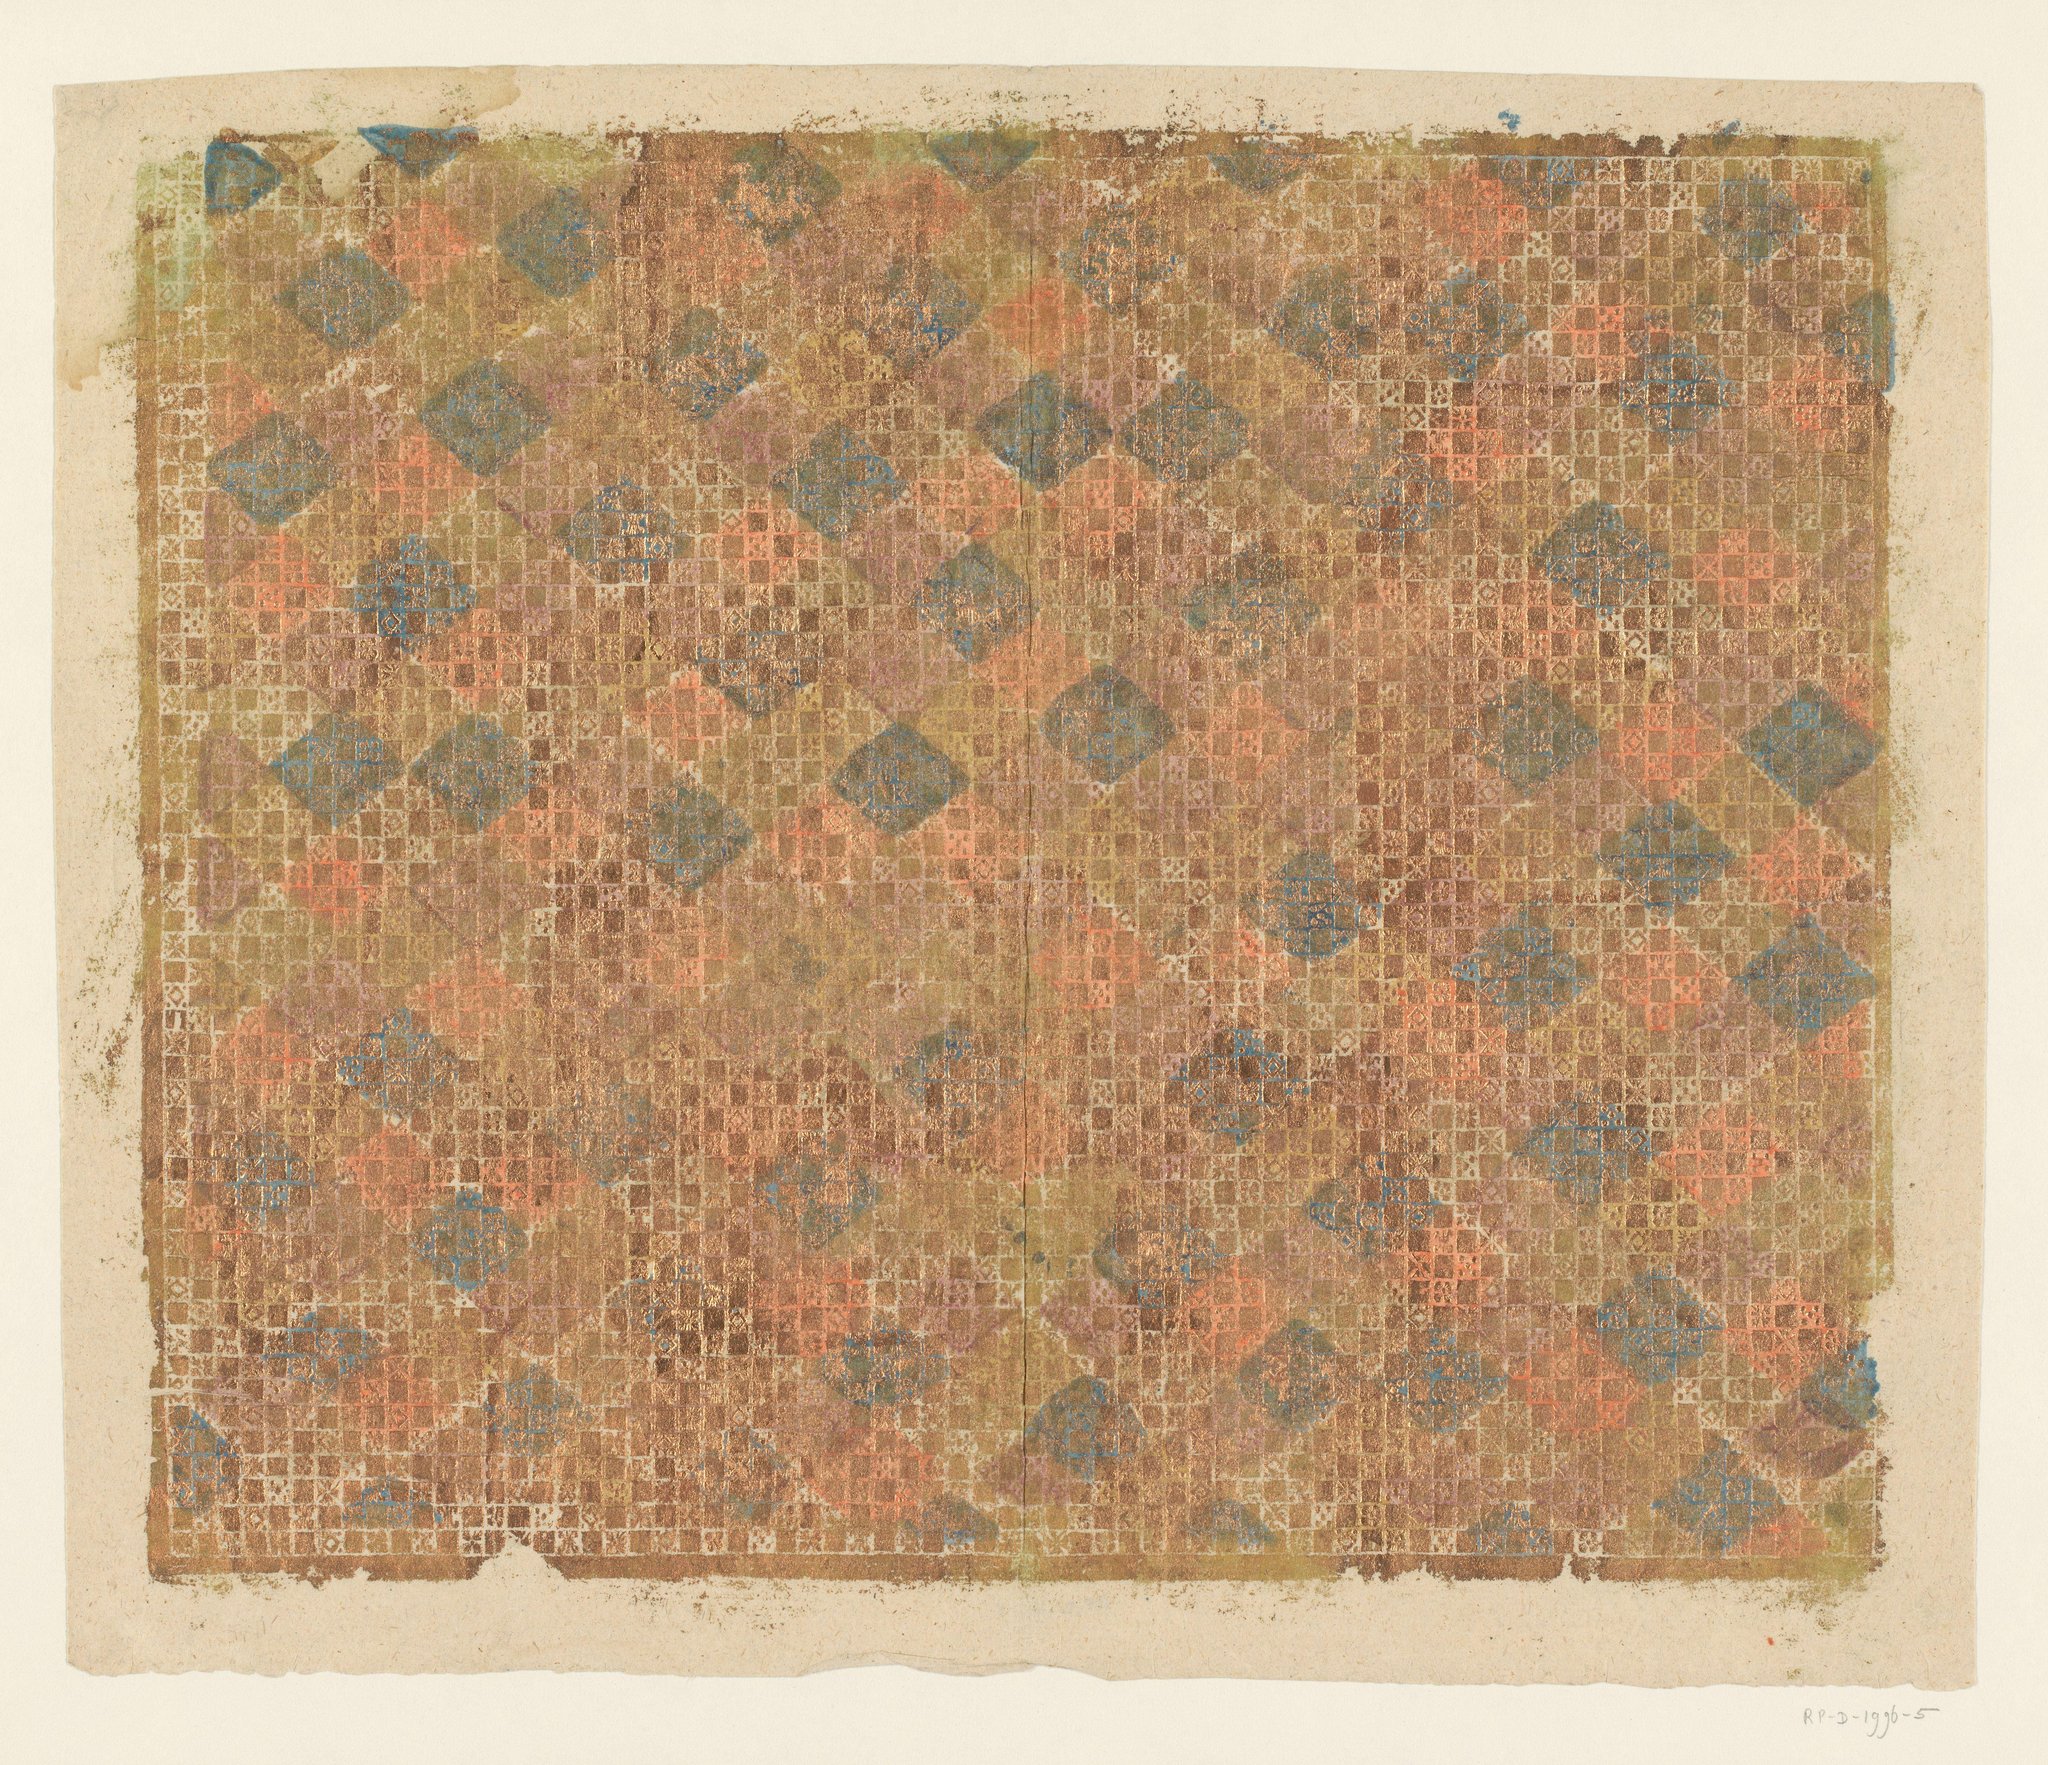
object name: brocade paper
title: Blad met schaakbordpatroon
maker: Anonymous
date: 1700-1800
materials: gold leaf, paint, paper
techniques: relief print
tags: ornament ~ geometric motifs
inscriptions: collector's mark: Lugt 2228, collector's mark: Lugt 2760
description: Blad met schaakbordpatroon met afwisselend vierkant in geheel goud, twee soorten rozetten, dobbelsteen vijf en een ruit met vier punten.